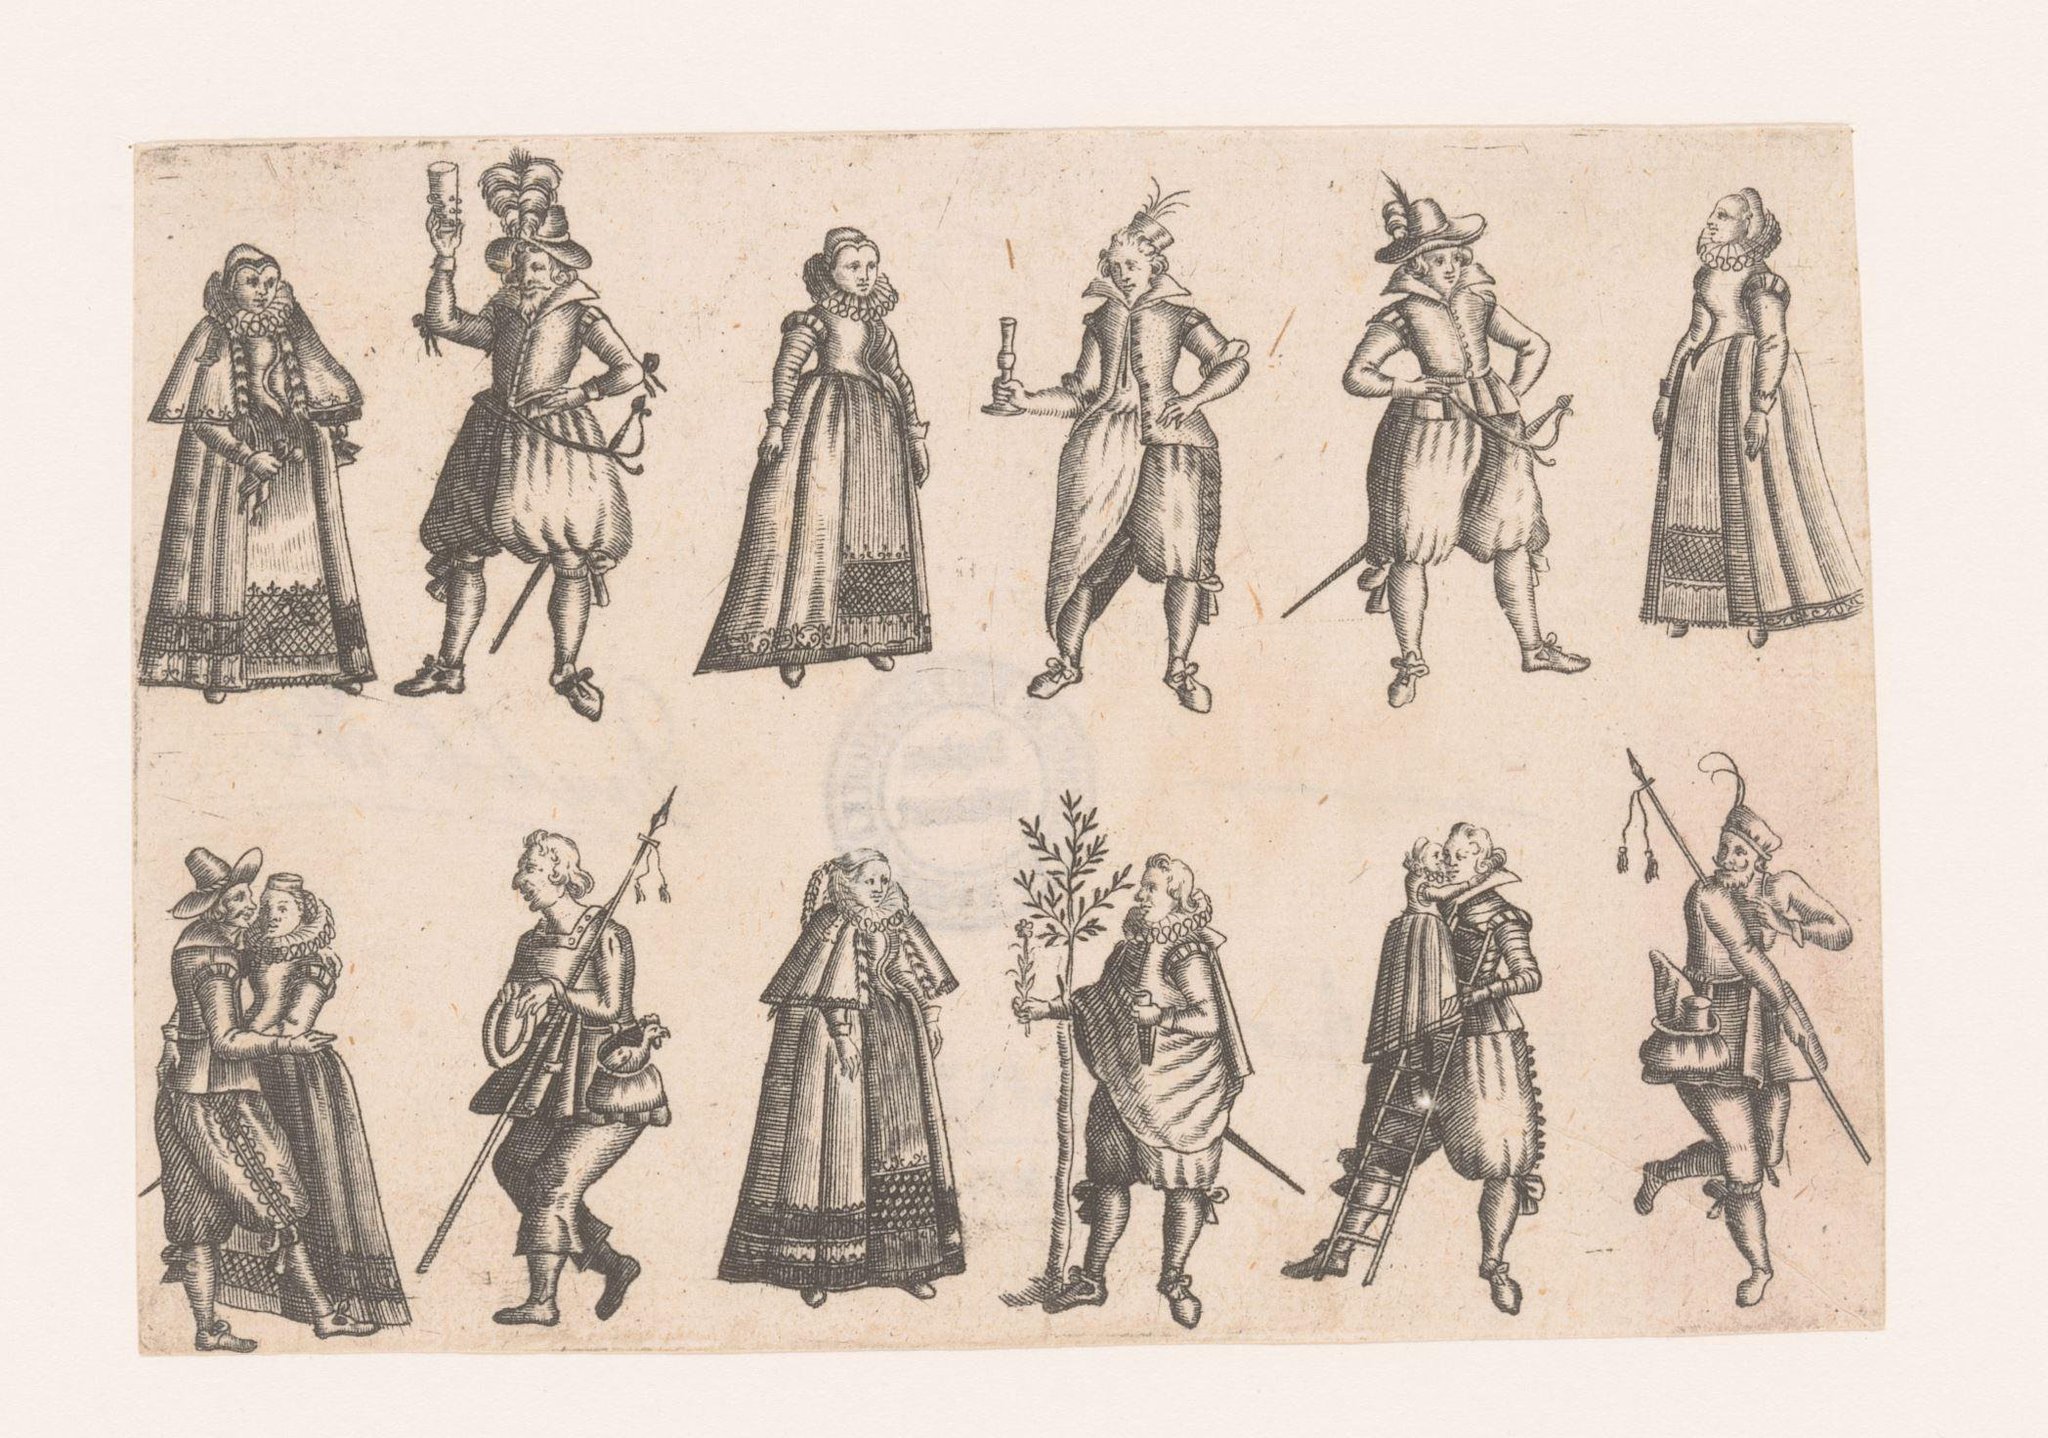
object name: costume print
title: Studie van twaalf figuren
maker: Anonymous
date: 1550-1649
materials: paper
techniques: engraving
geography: germany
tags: clothes, costume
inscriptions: collector's mark: ‘Sachsisches Kupferstichkabinett duplum veräussert’, collector's mark: Lugt 2228